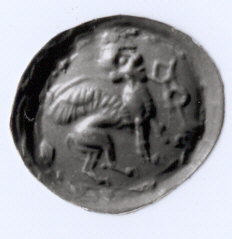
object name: stamp seal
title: Conoid seal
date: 1200-801 BCE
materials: mineral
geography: cyprus (?)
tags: sphinx